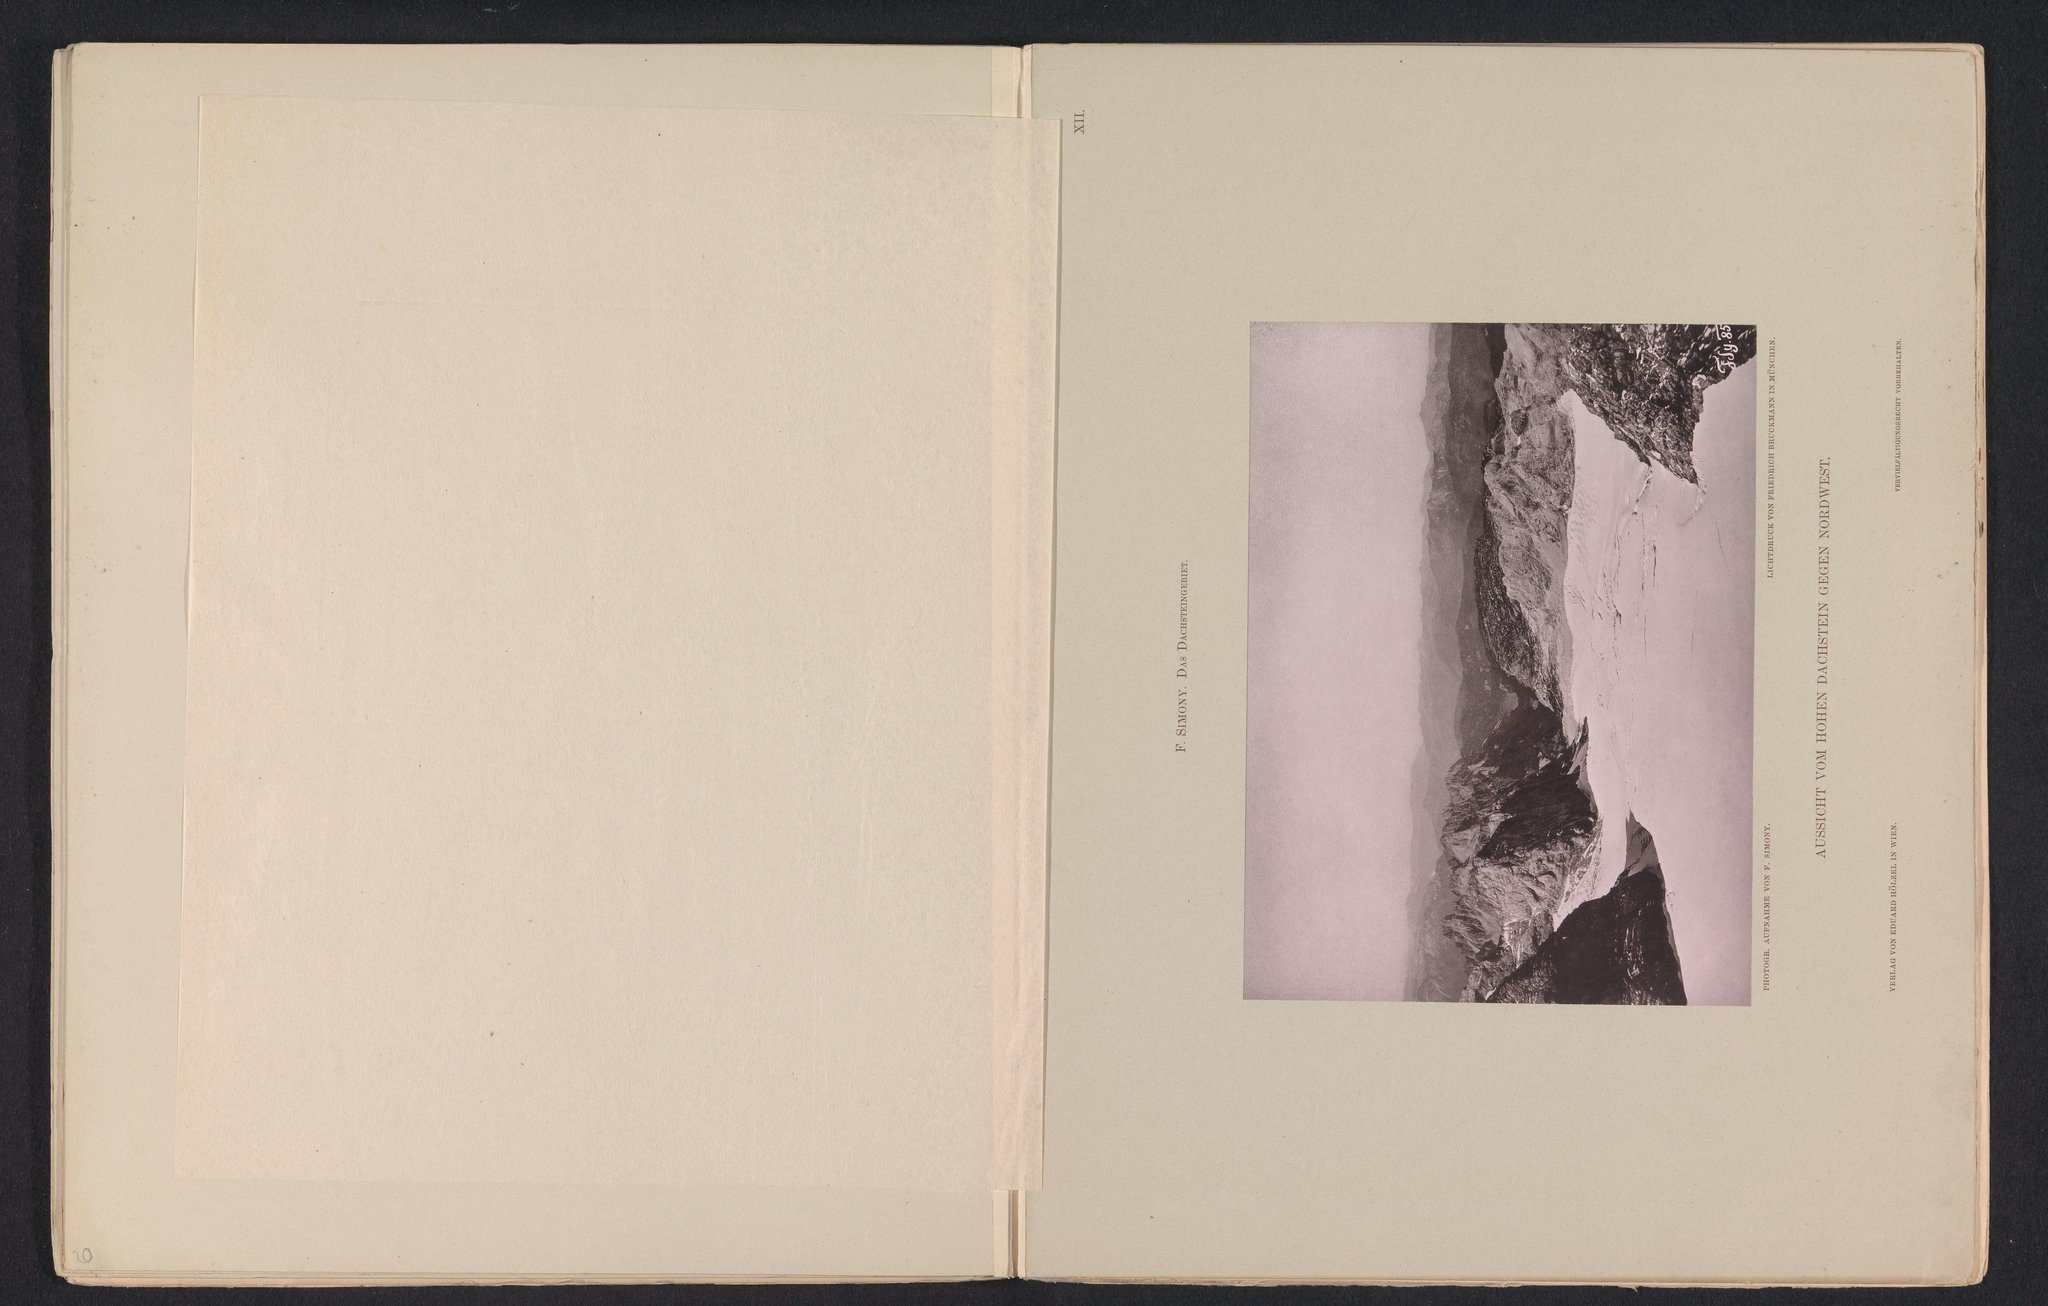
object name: page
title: Aussicht vom Hohen Dachstein gegen nordwest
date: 1885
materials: paper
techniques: photograph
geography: vienna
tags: mountain-top, peak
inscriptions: number: ‘XII.’